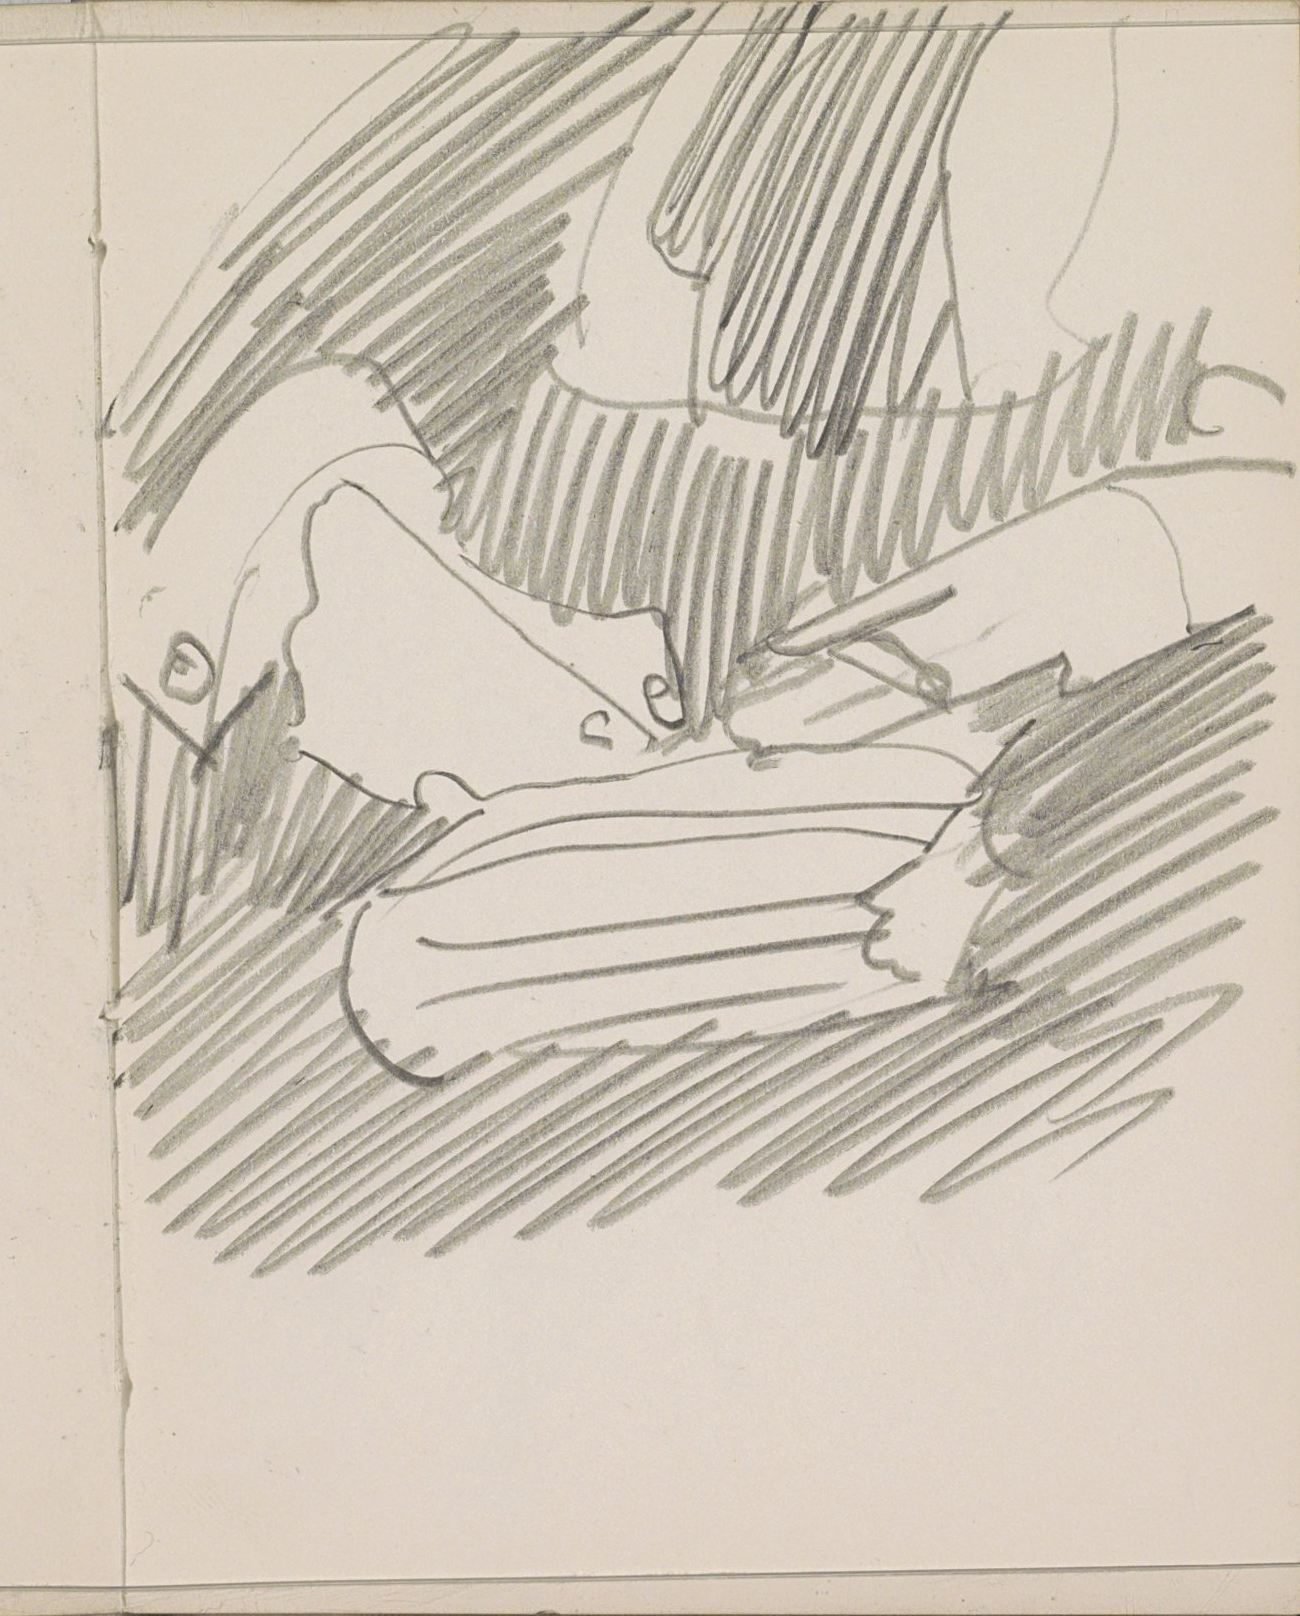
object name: sketchbook leaf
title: Studie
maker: reijer stolk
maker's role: draughtsman, print maker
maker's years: 1896-1945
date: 1916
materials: paper, pencil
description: Blad 10 recto uit een schetsboek met 72 bladen.